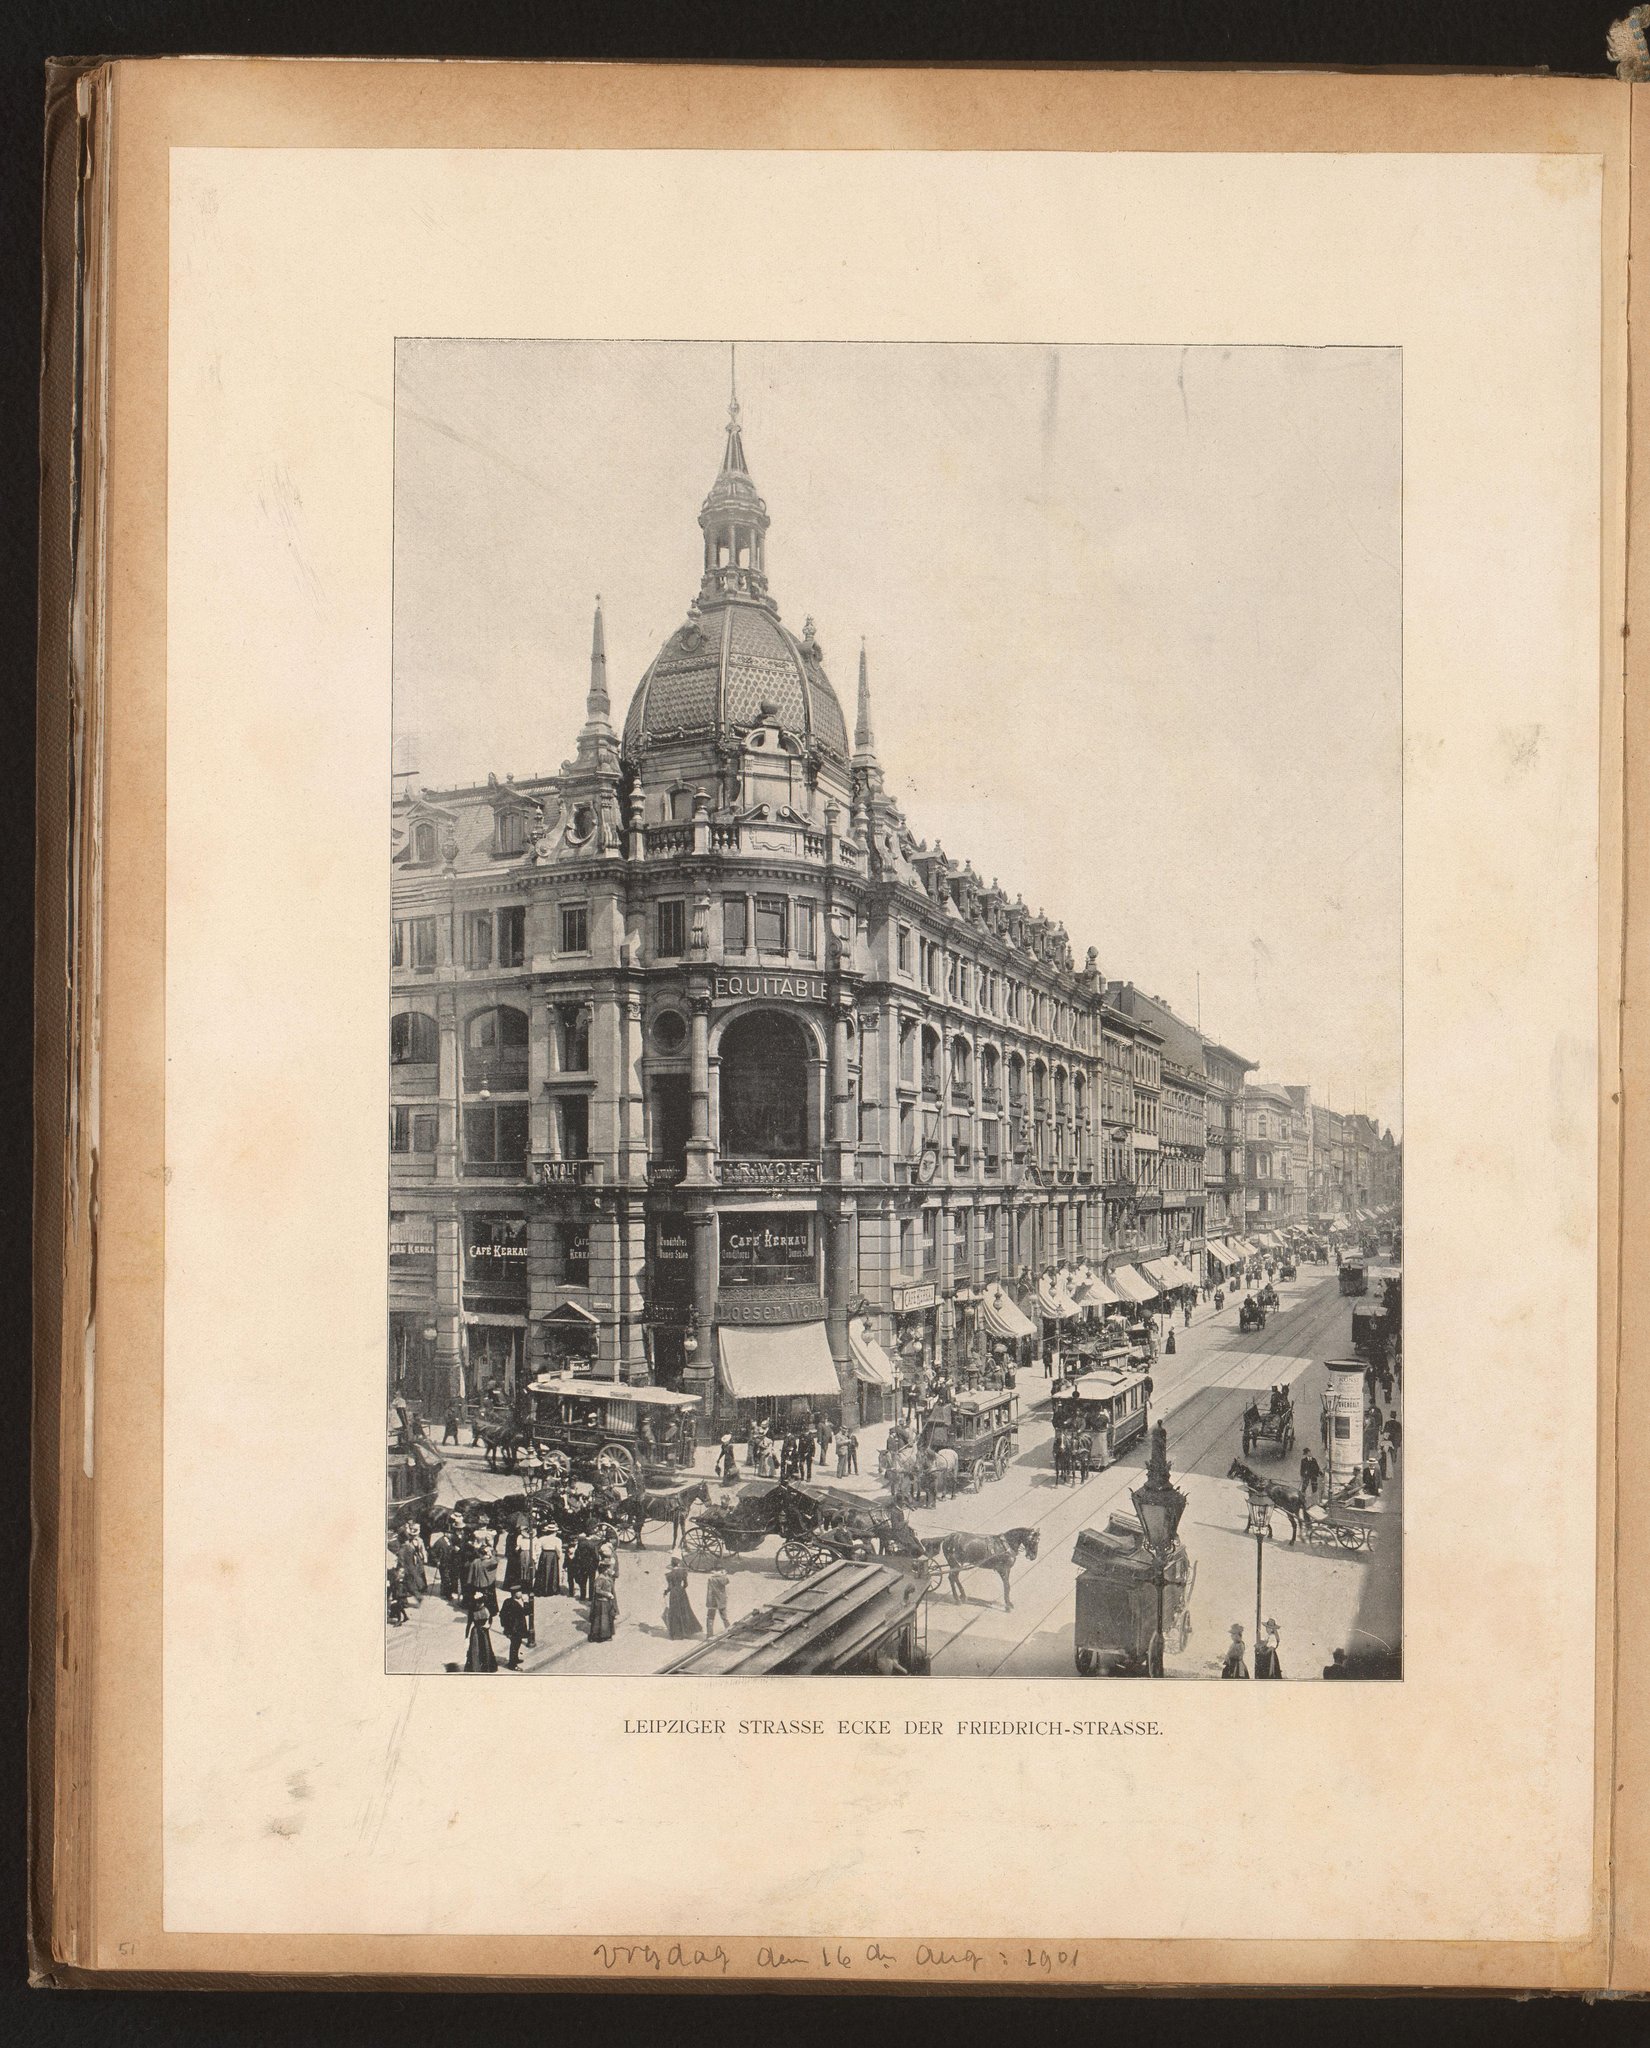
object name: photomechanical print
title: Gezicht op de hoek van de Leipziger Strasse en de Friedrichstrasse, Berlijn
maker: Anonymous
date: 1896-1901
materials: paper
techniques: autotype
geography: berlin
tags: street, front façade, berlin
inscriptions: inscription: ‘Vrijdag den 16de Aug: 1901’, title: ‘Leipziger Strasse Ecke der Friedrich-Strasse.’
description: Deze fotomechanische afdruk maakt deel uit van een album.